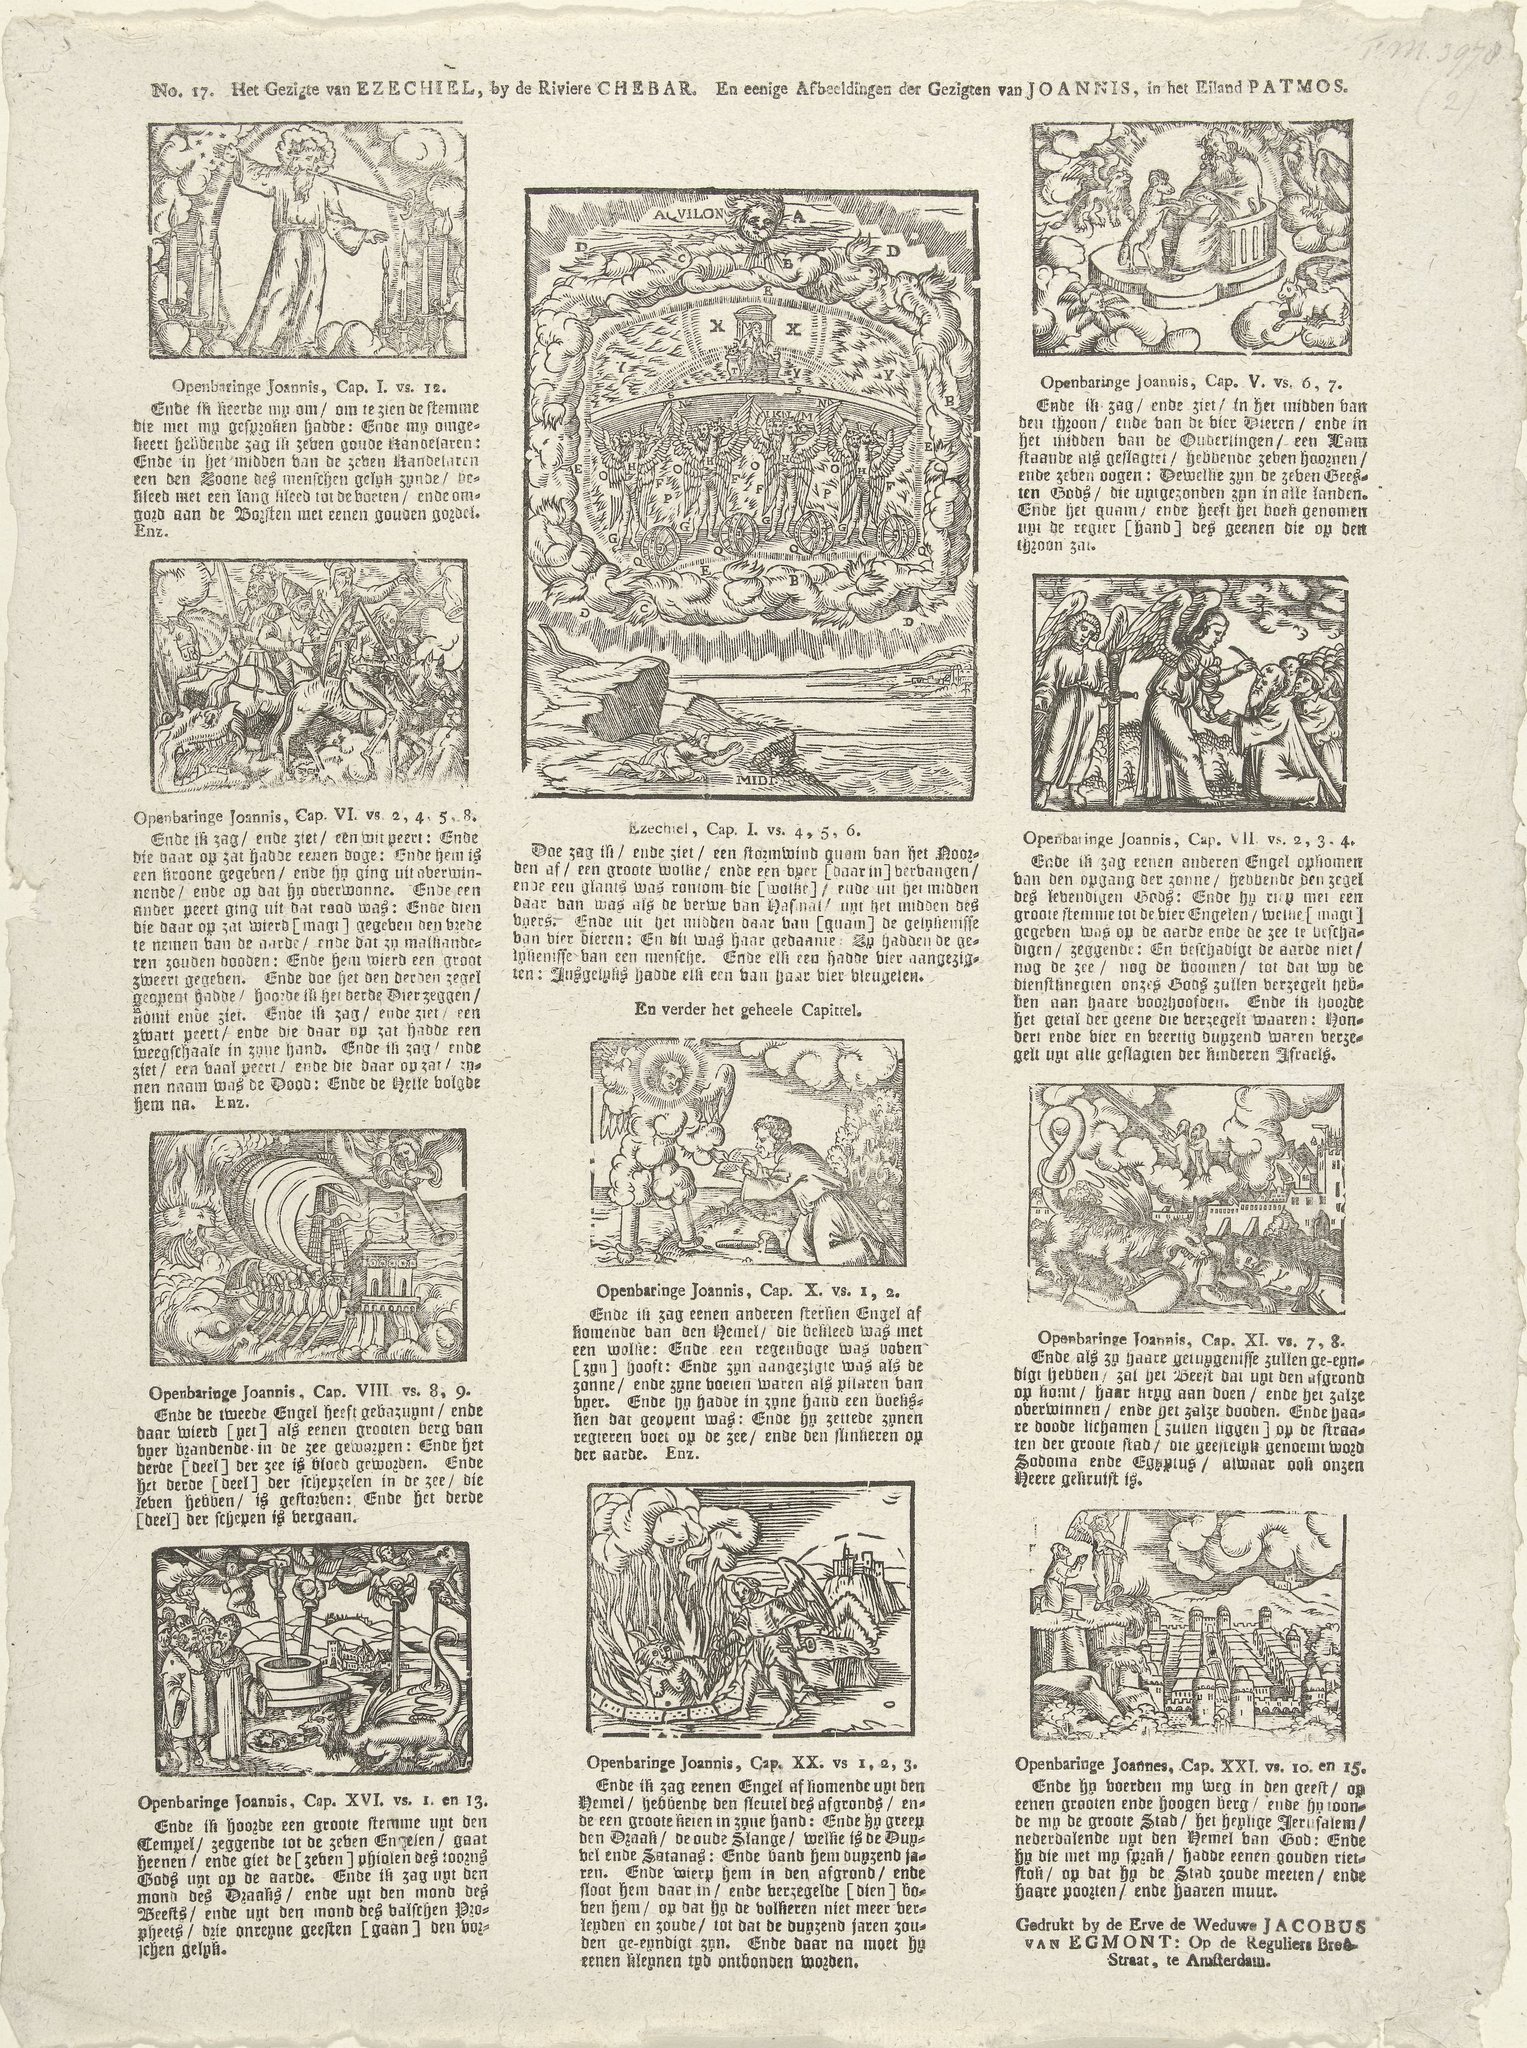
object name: print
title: Het gezigte van Ezechiel, by de riviere Chebar. En eenige afbeeldingen der gezigten van Joannis, in het eiland Patmos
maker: Anonymous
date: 1761-1804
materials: paper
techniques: letterpress printing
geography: amsterdam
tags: ezekiel's visions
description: Blad met een grote voorstelling van het visioen van Ezechiël en tien kleinere voorstellingen van de visioenen van de openbaring aan Johannes de Evangelist op Patmos. Onder elke voorstelling een verwijzing naar de relevante bijbelverzen met bijbelcitaat. Genummerd linksboven: No. 17.